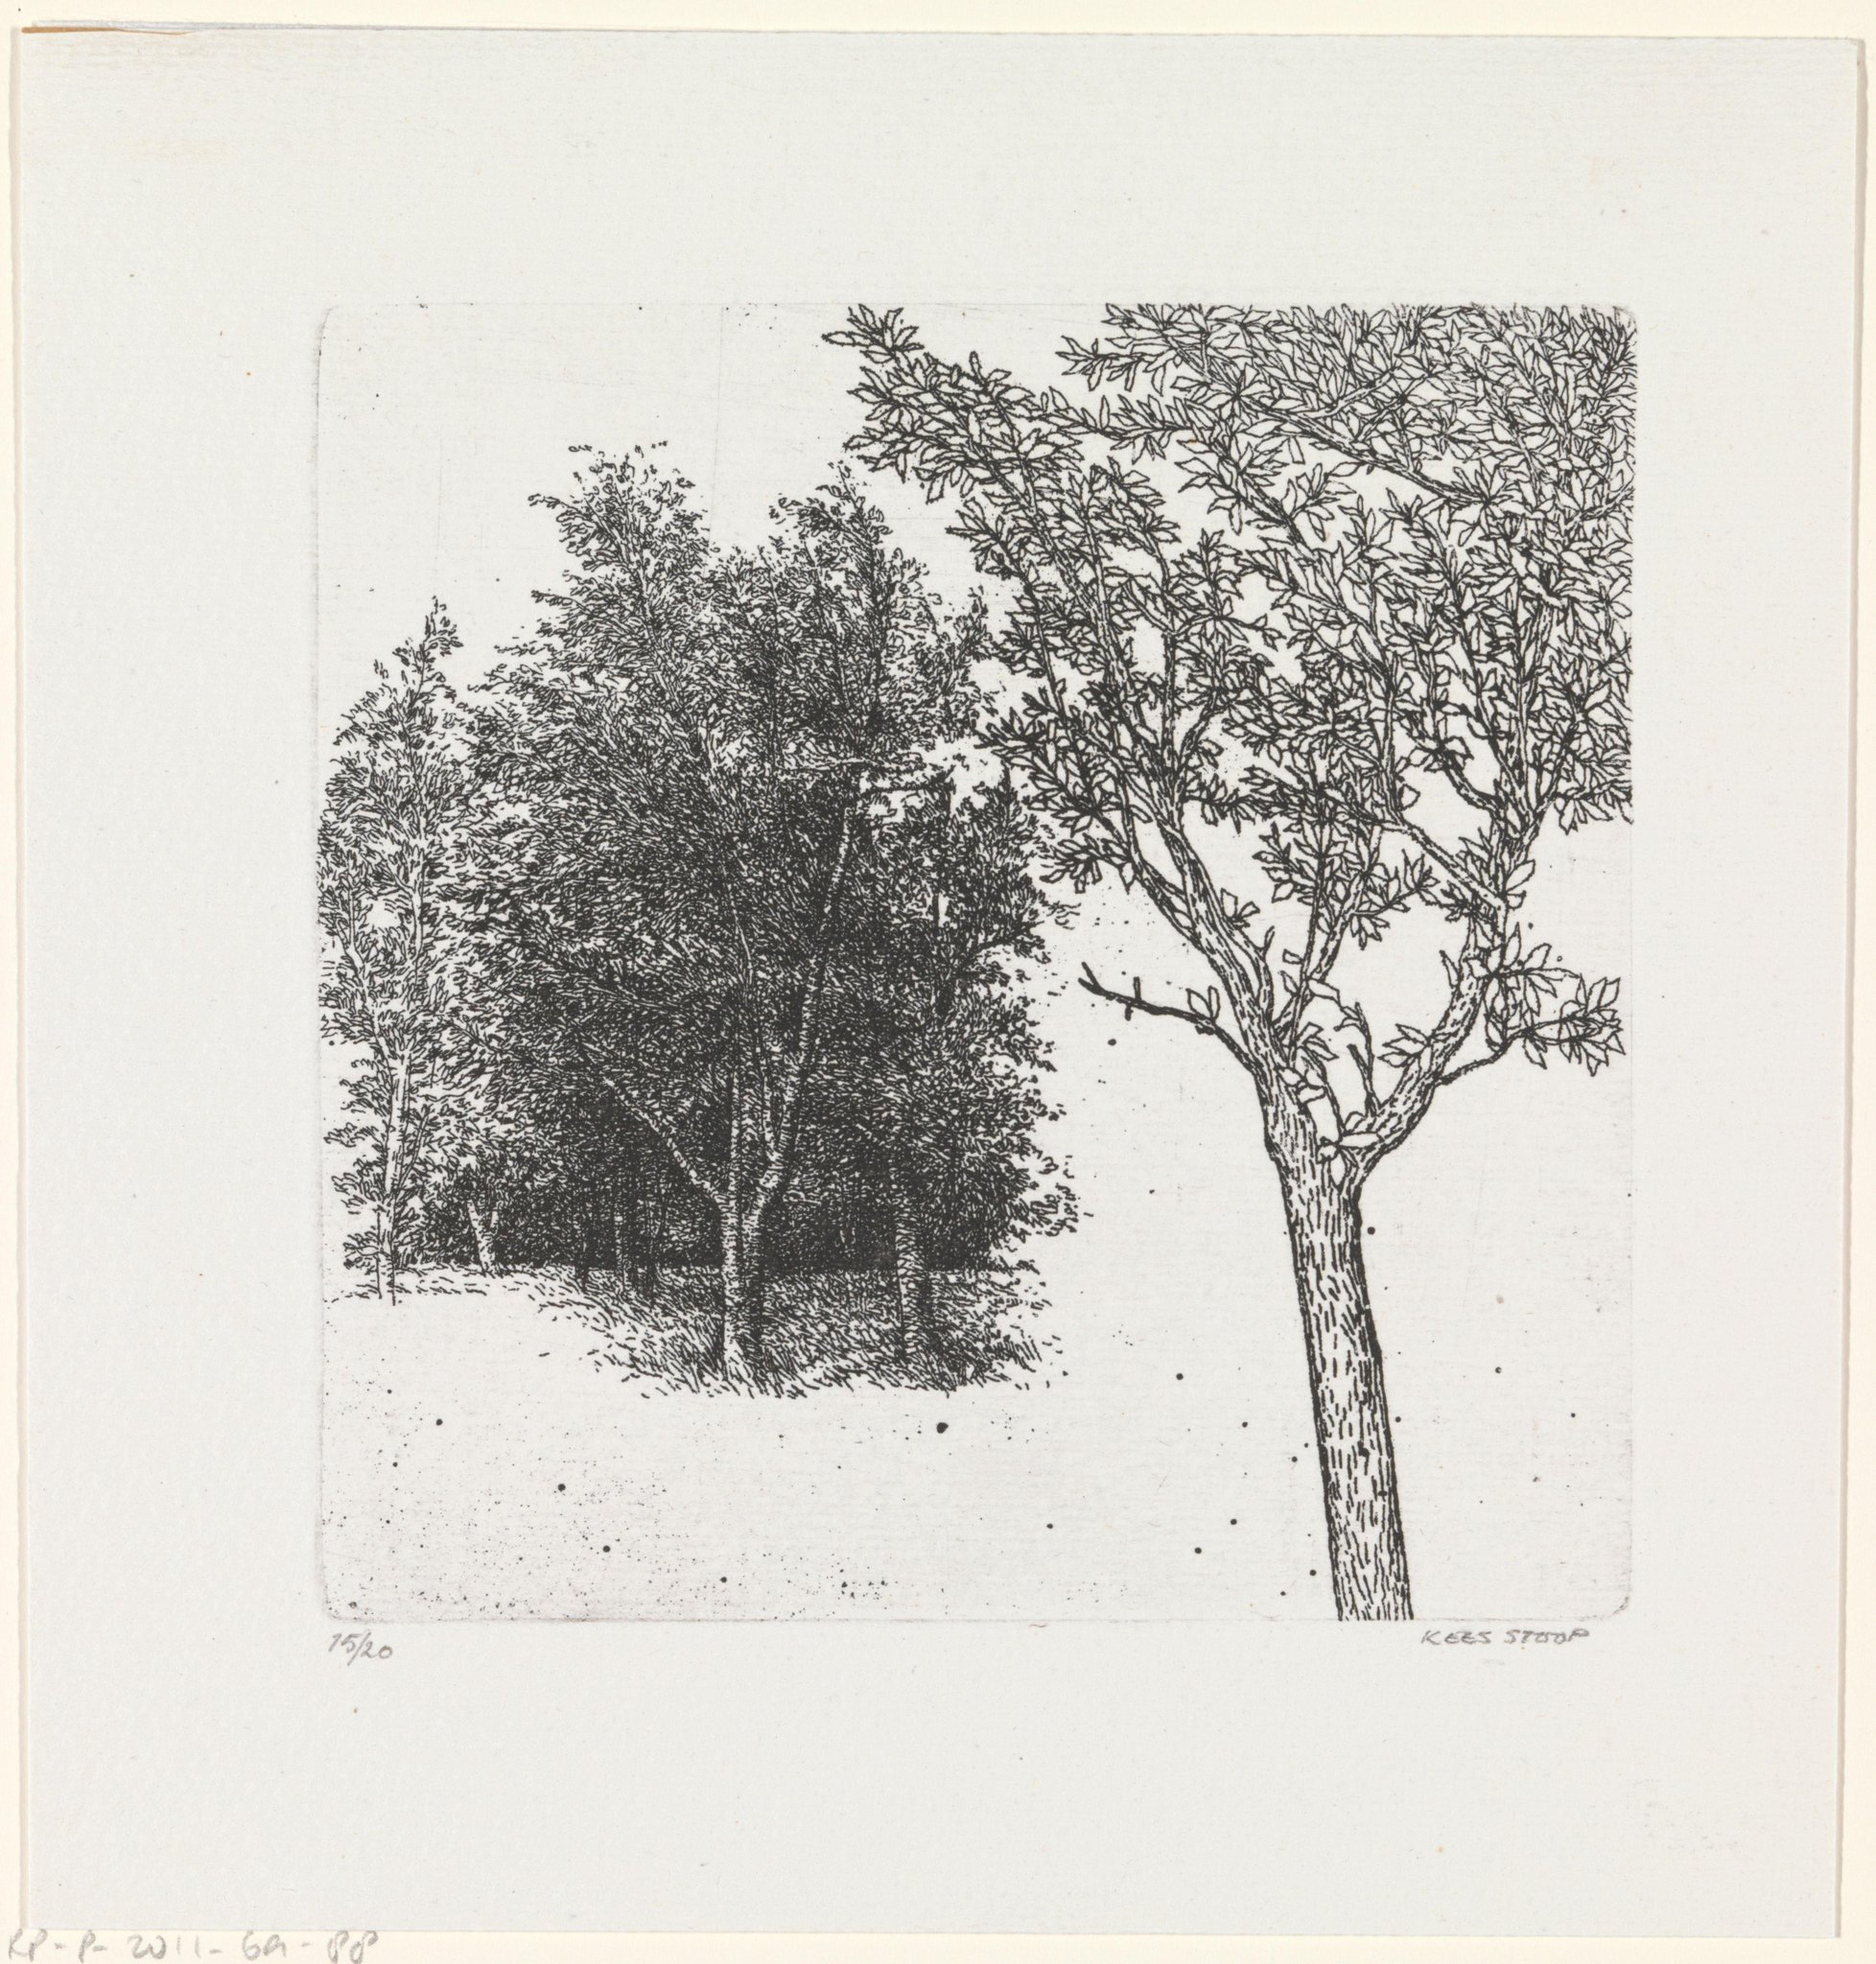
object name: print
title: Bomen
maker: kees stoop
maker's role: draughtsman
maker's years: 1929-2019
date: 1976-1977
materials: paper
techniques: etching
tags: trees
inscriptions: edition: ‘15/20’, signature: ‘KEES STOOP’, date: ‘IN: c. 76-77?’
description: Groep bomen links en vrijstaande boom rechts.